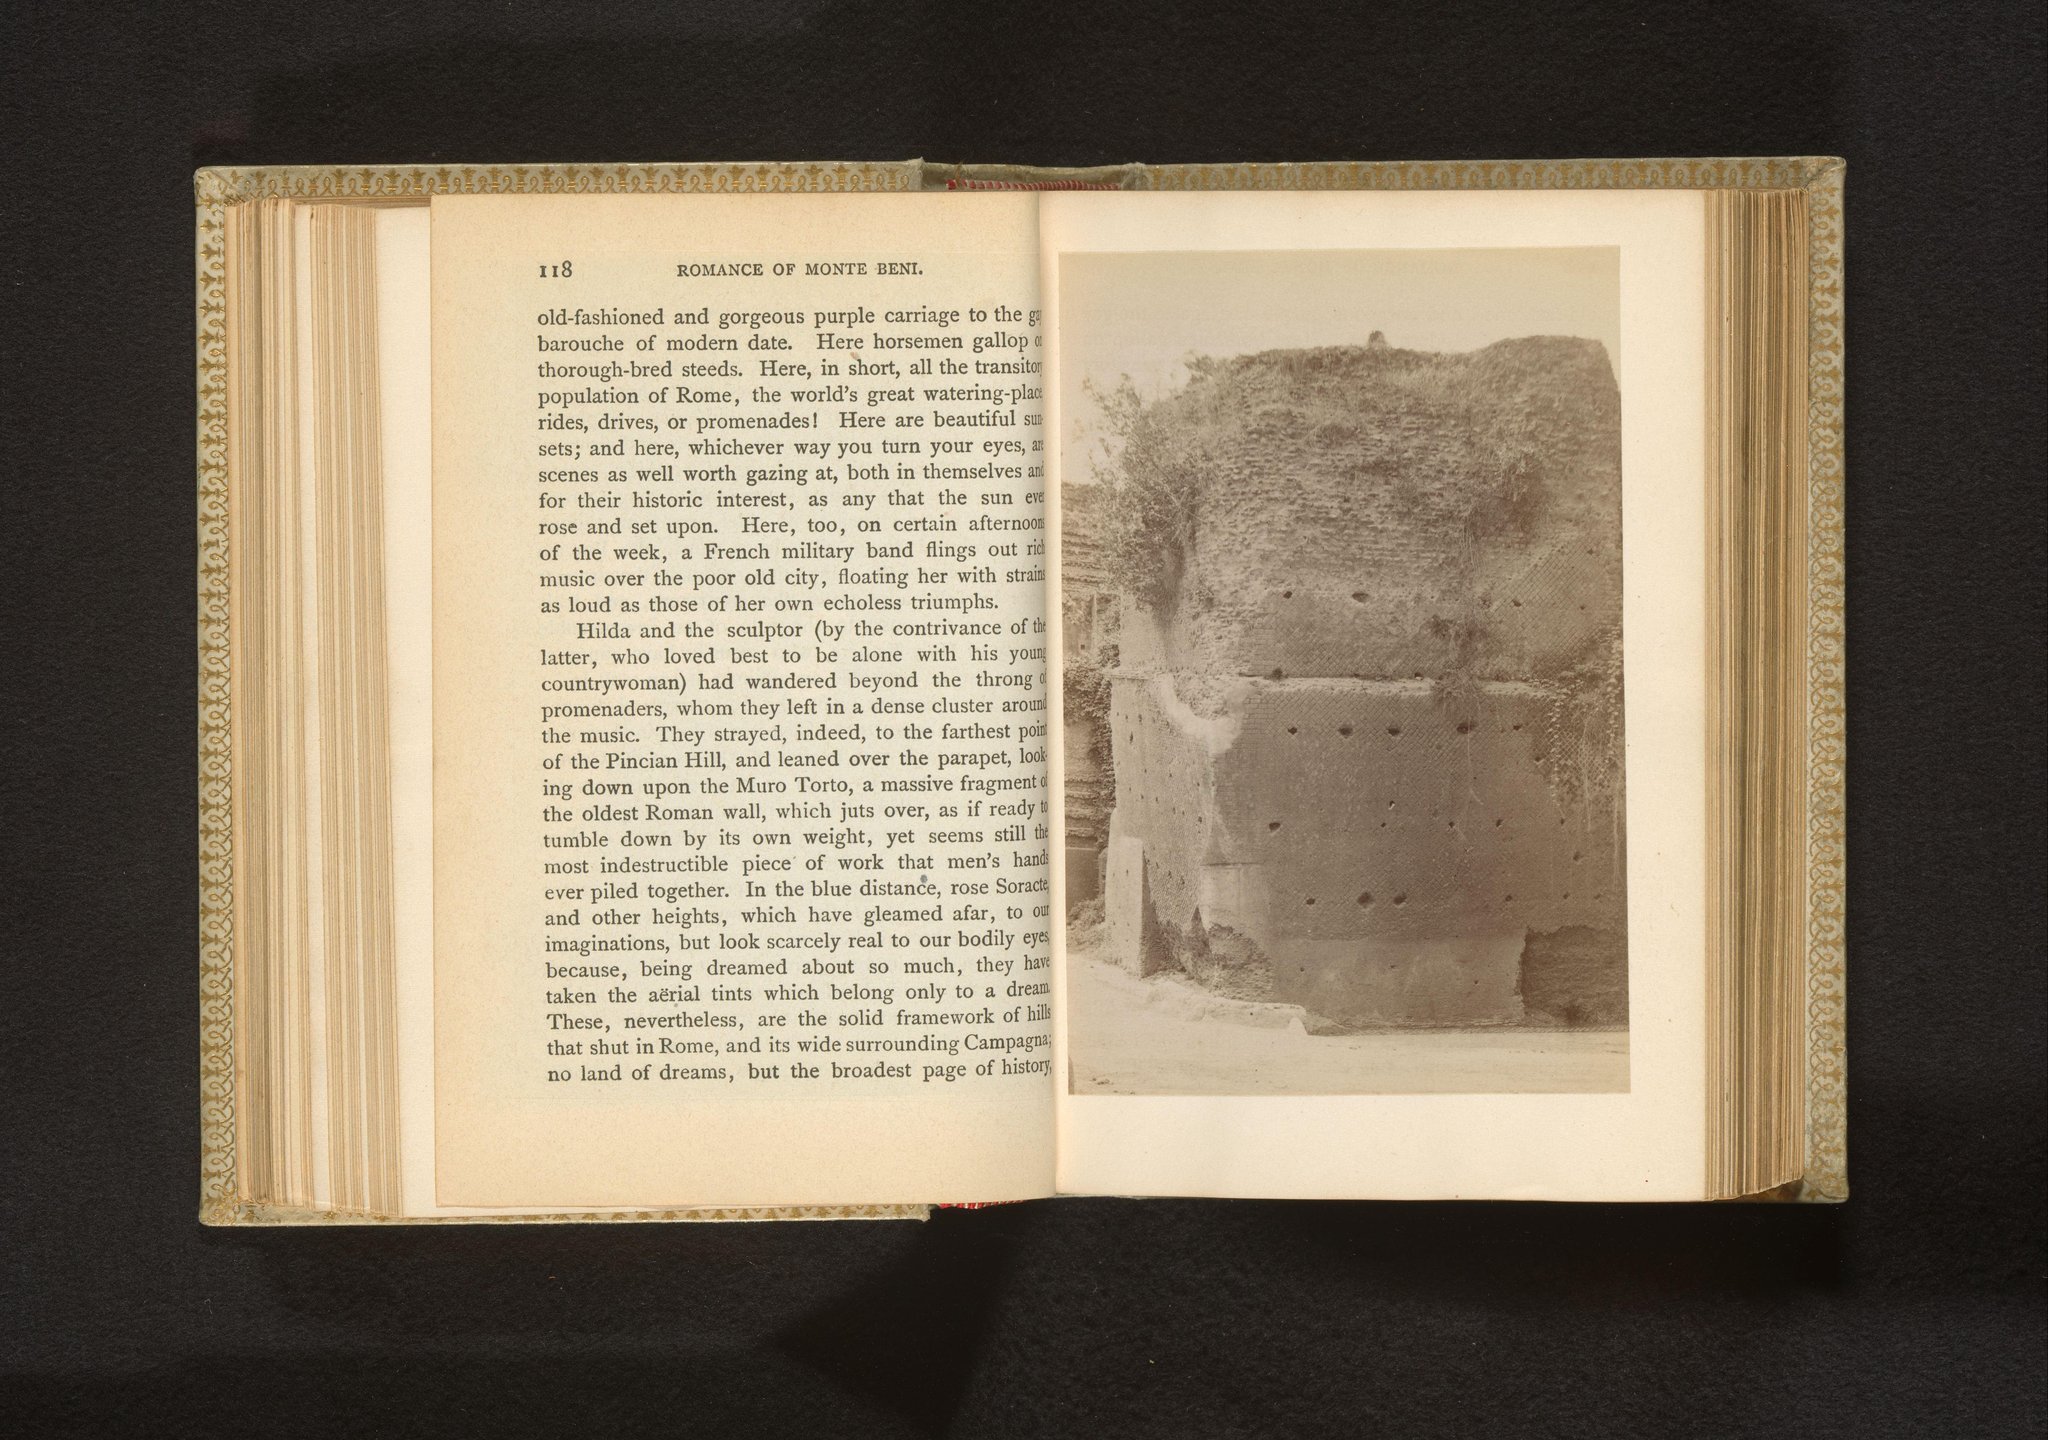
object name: photograph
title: Gezicht op een stuk van de Muro Torto, de oude stadsmuur van Rome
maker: Anonymous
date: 1850-1860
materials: photographic support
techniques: albumen print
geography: rome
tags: city-walls, rome